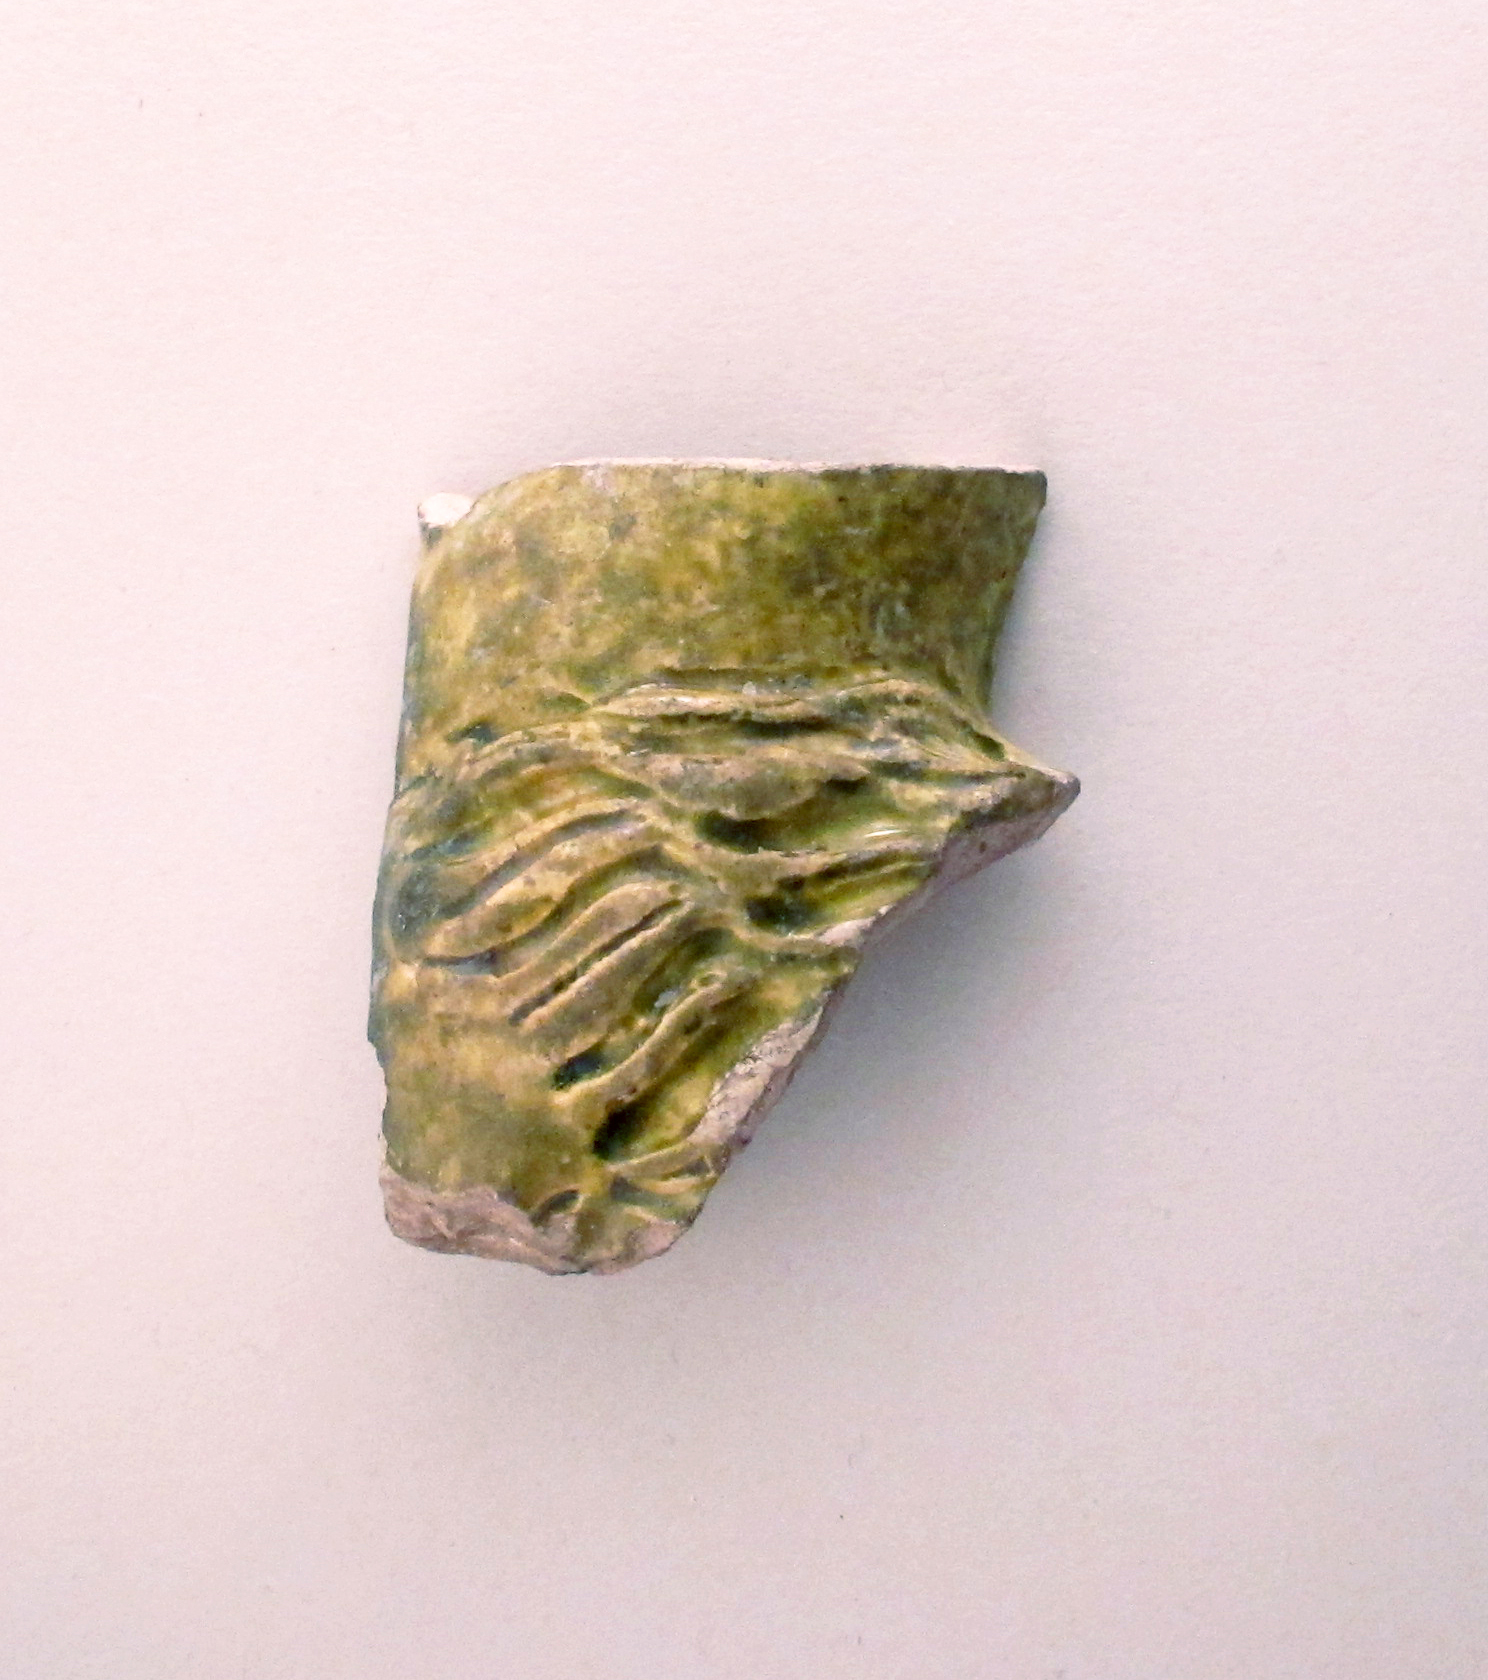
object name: vase fragment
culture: roman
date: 670 BCE-330 CE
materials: terracotta